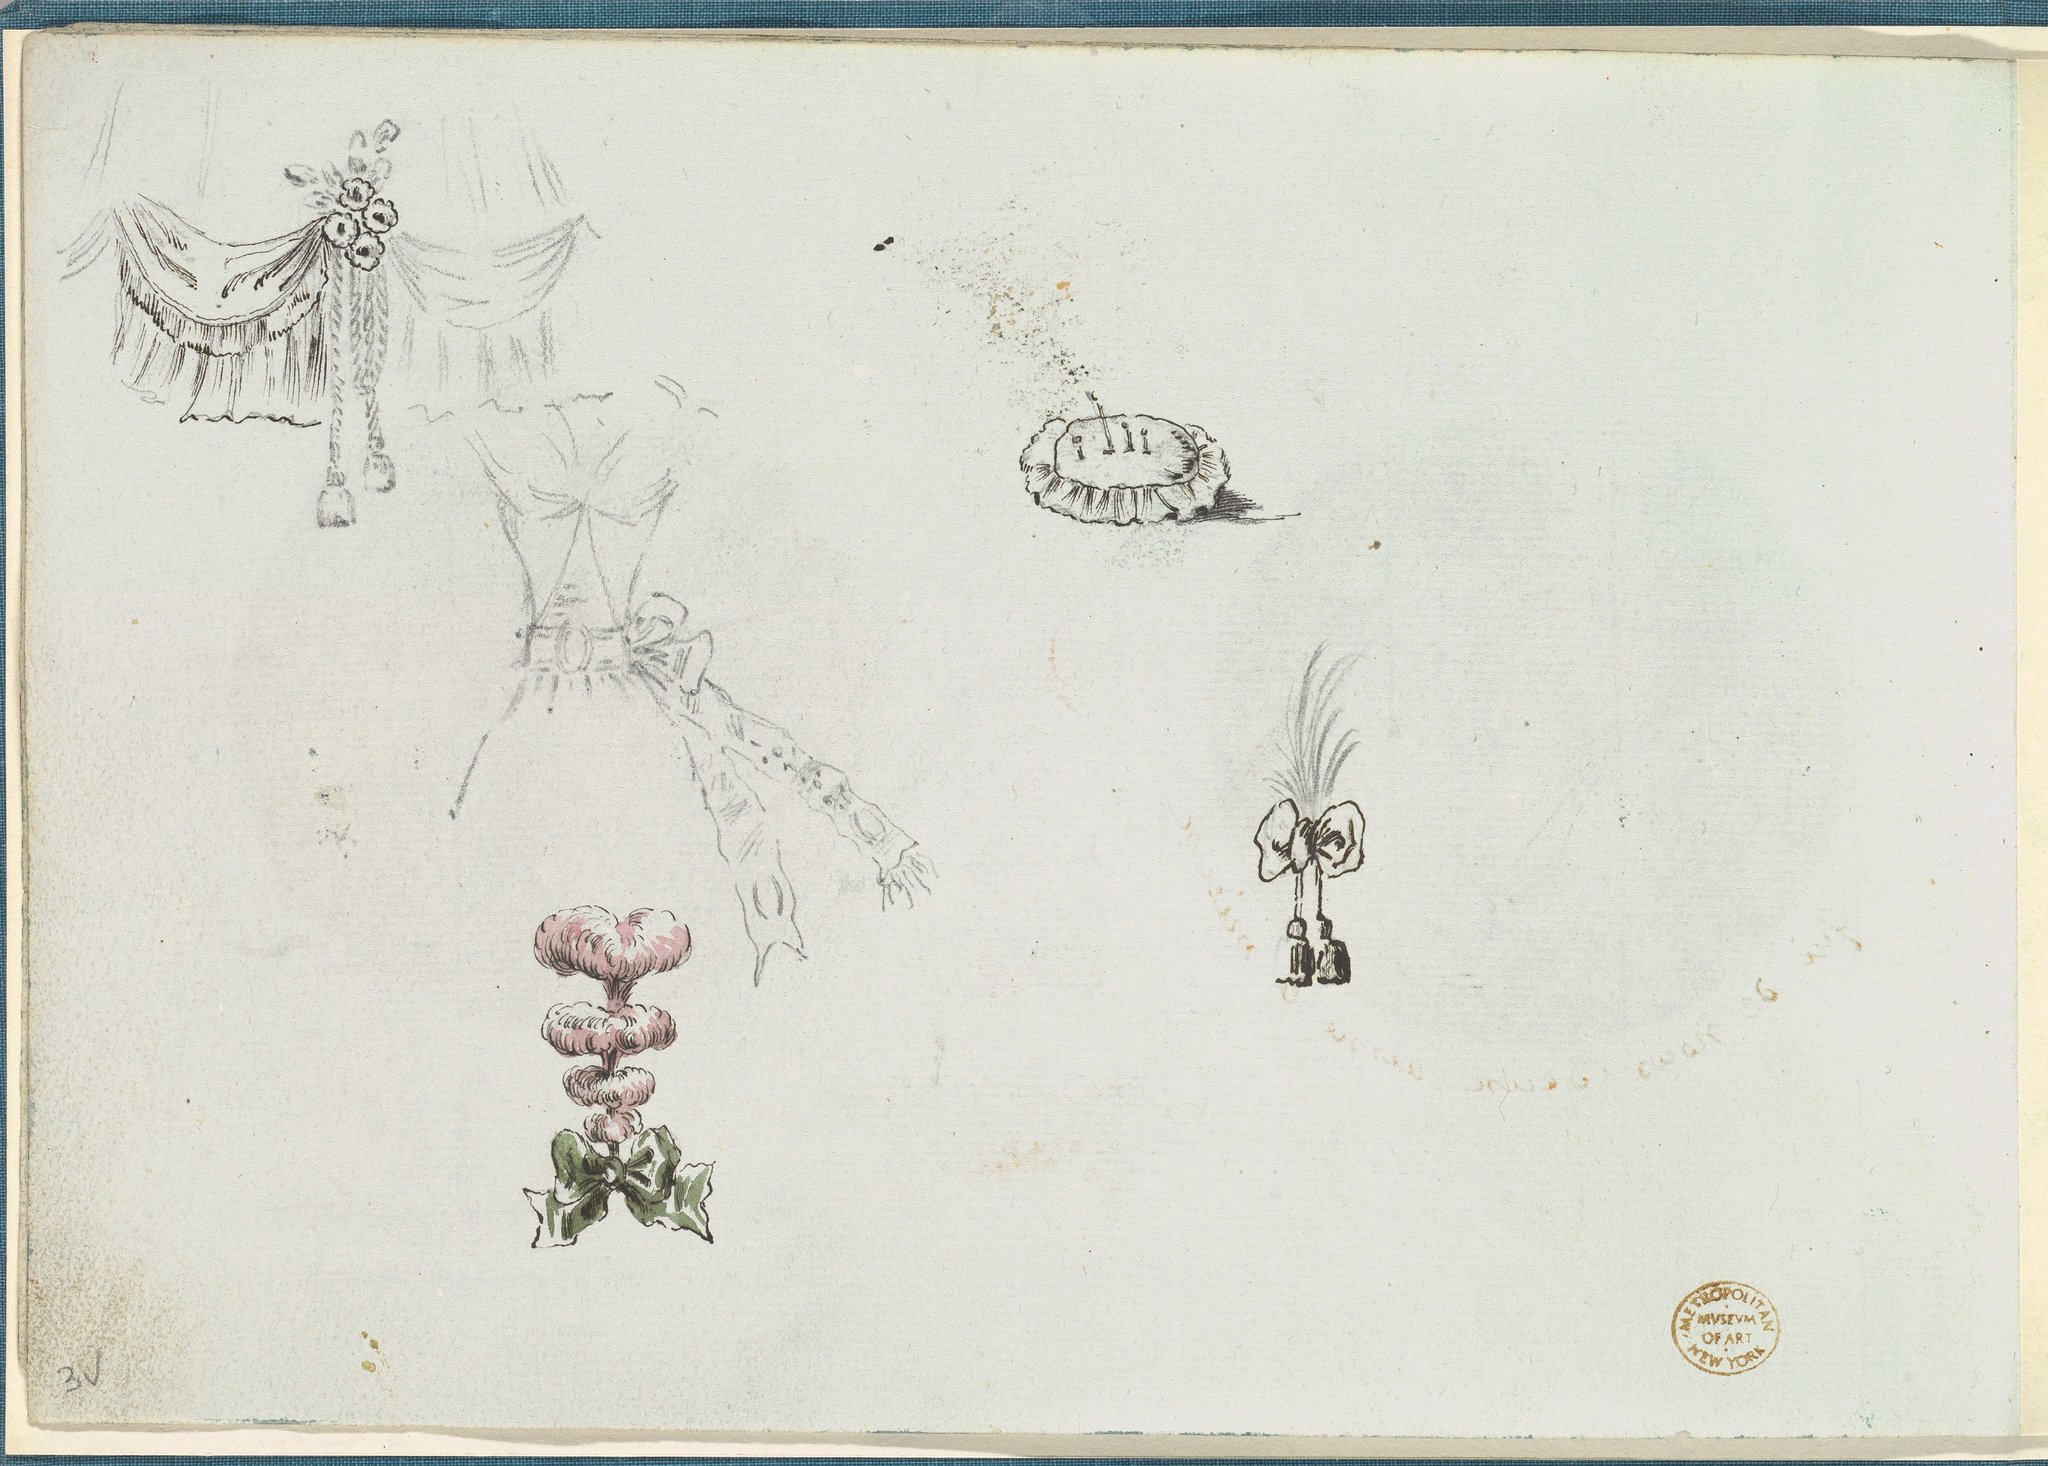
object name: collection ornament architecture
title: Sketches for Details of a Dress and Other Accessories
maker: anonymous, french, 18th century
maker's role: artist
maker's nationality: french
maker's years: 1700-1800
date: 1785-1790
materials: gouache, graphite, ink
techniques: pen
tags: dresses,flowers